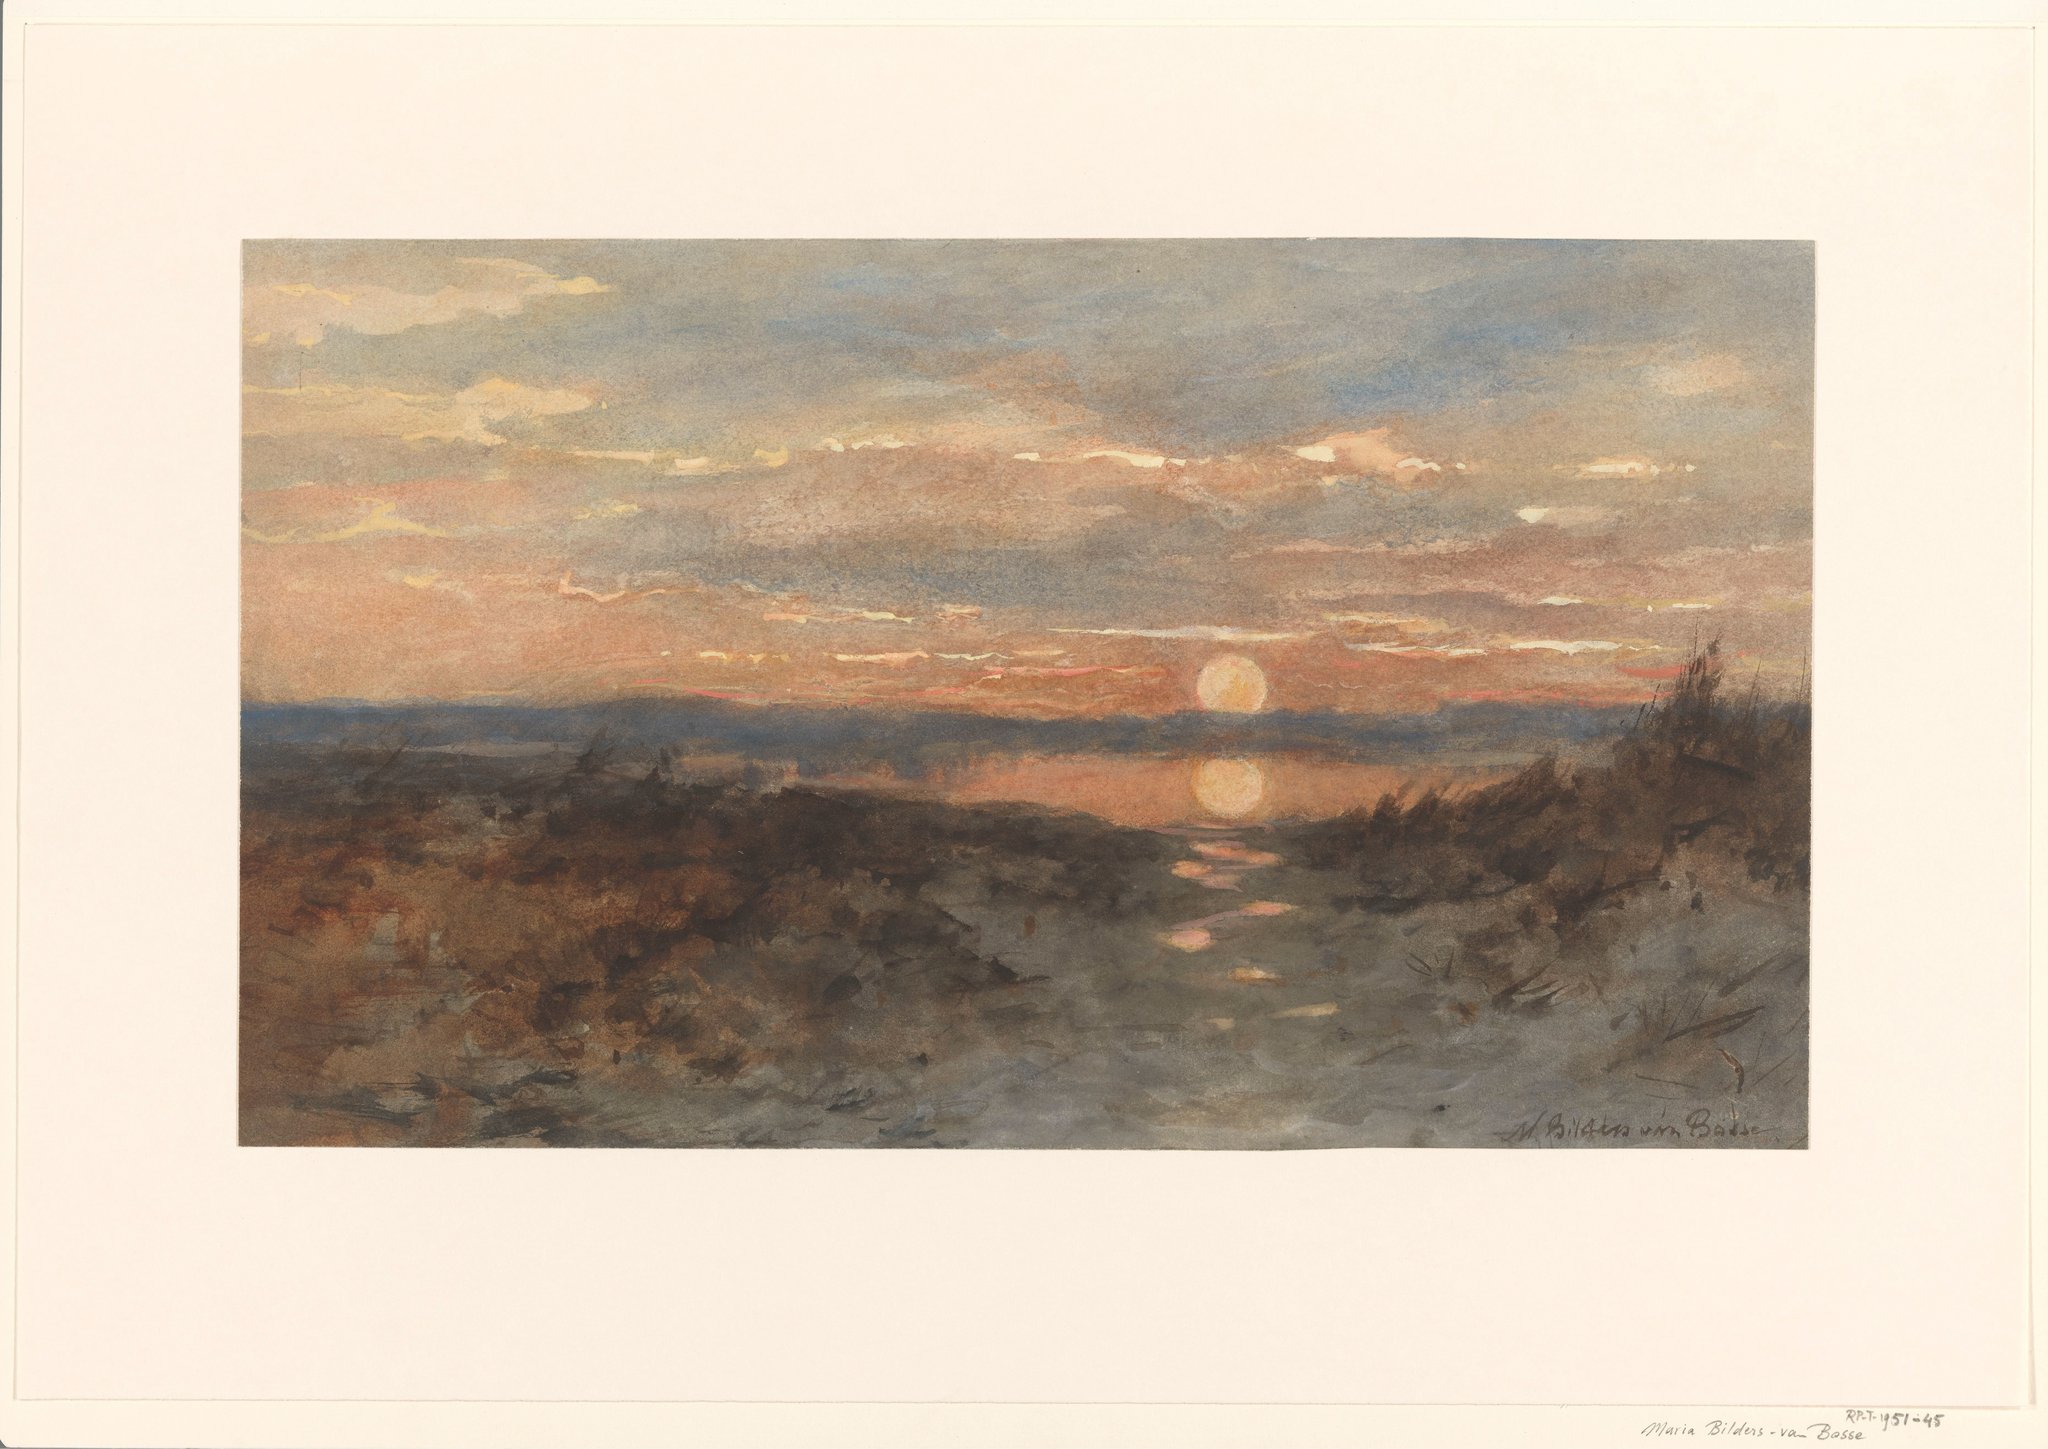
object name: watercolor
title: Landschap met zonsondergang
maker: maria bilders-van bosse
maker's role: draughtsman, painter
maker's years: 1837-1900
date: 1847-1900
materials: paper, watercolor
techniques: brush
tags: landscapes in the temperate zone, sunset